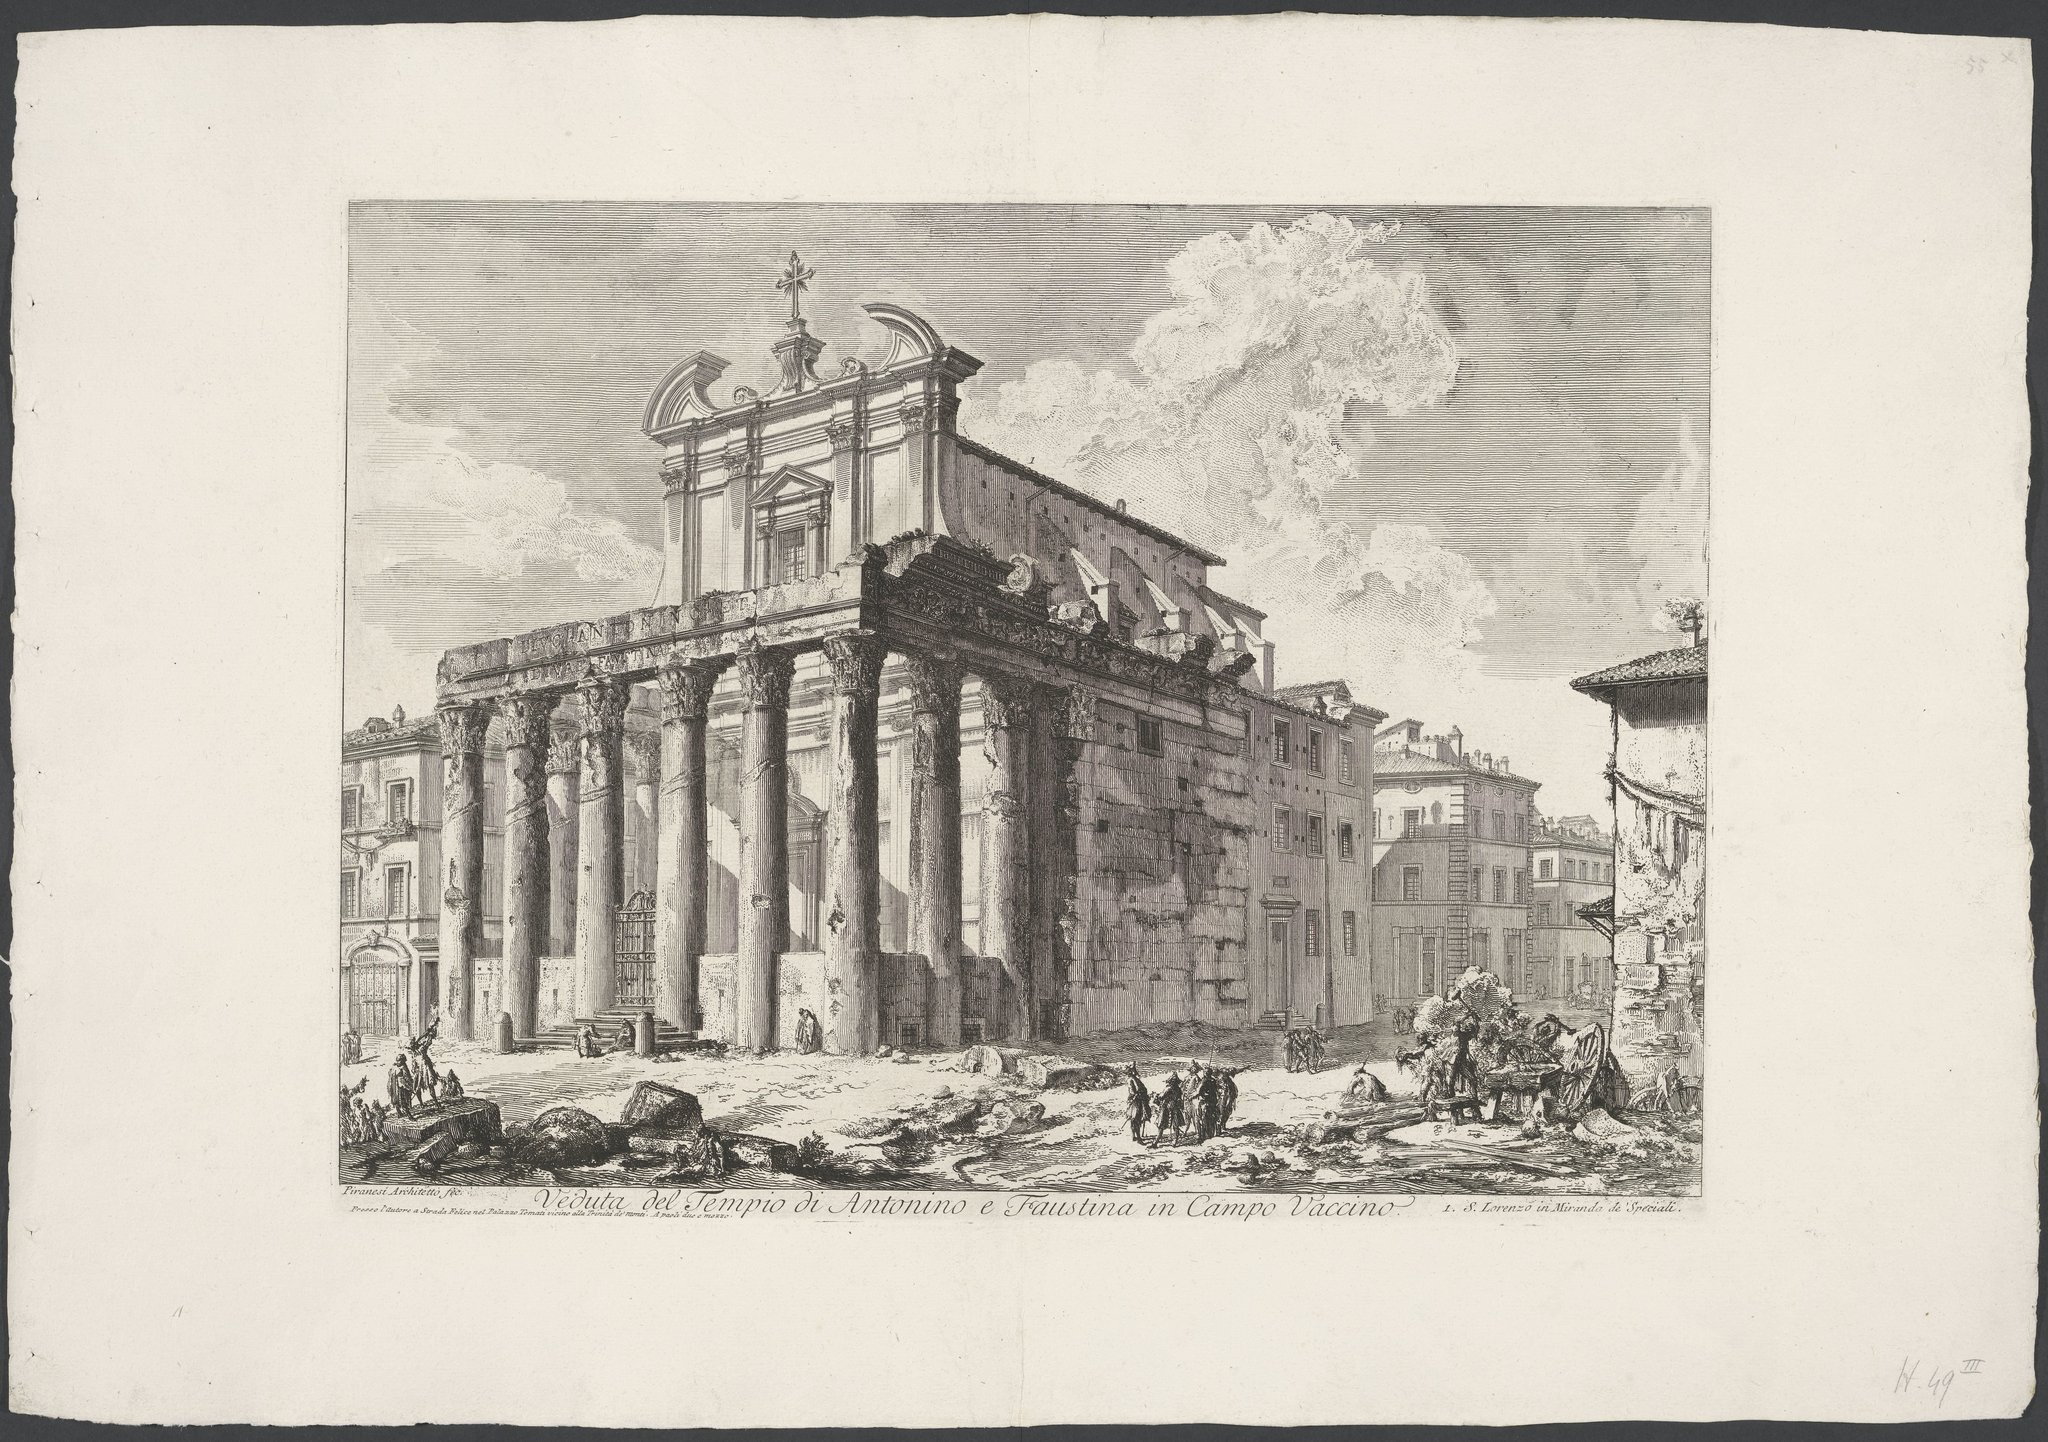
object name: print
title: Vedute di Roma disegnate ed incise da Giambattista Piranesi architetto Ve(nez)iano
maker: giovanni battista piranesi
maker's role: designer, draughtsman, print maker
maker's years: 1720-1778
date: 1748-1778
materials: paper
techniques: etching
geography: rome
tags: ruin of a building ~ architecture, church (exterior), landscape with ruins, roman catholic church, temple, shrine ~ roman religion, rome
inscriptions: collector's mark: Lugt 2228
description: Deze prent maakt deel uit van de serie 'Vedute di Roma'. Piranesi werkte aan deze 135 platen tellende serie tussen 1748 en zijn dood in 1778. Francesco Piranesi voegde later nog twee prenten toe aan de reeks van zijn vader.